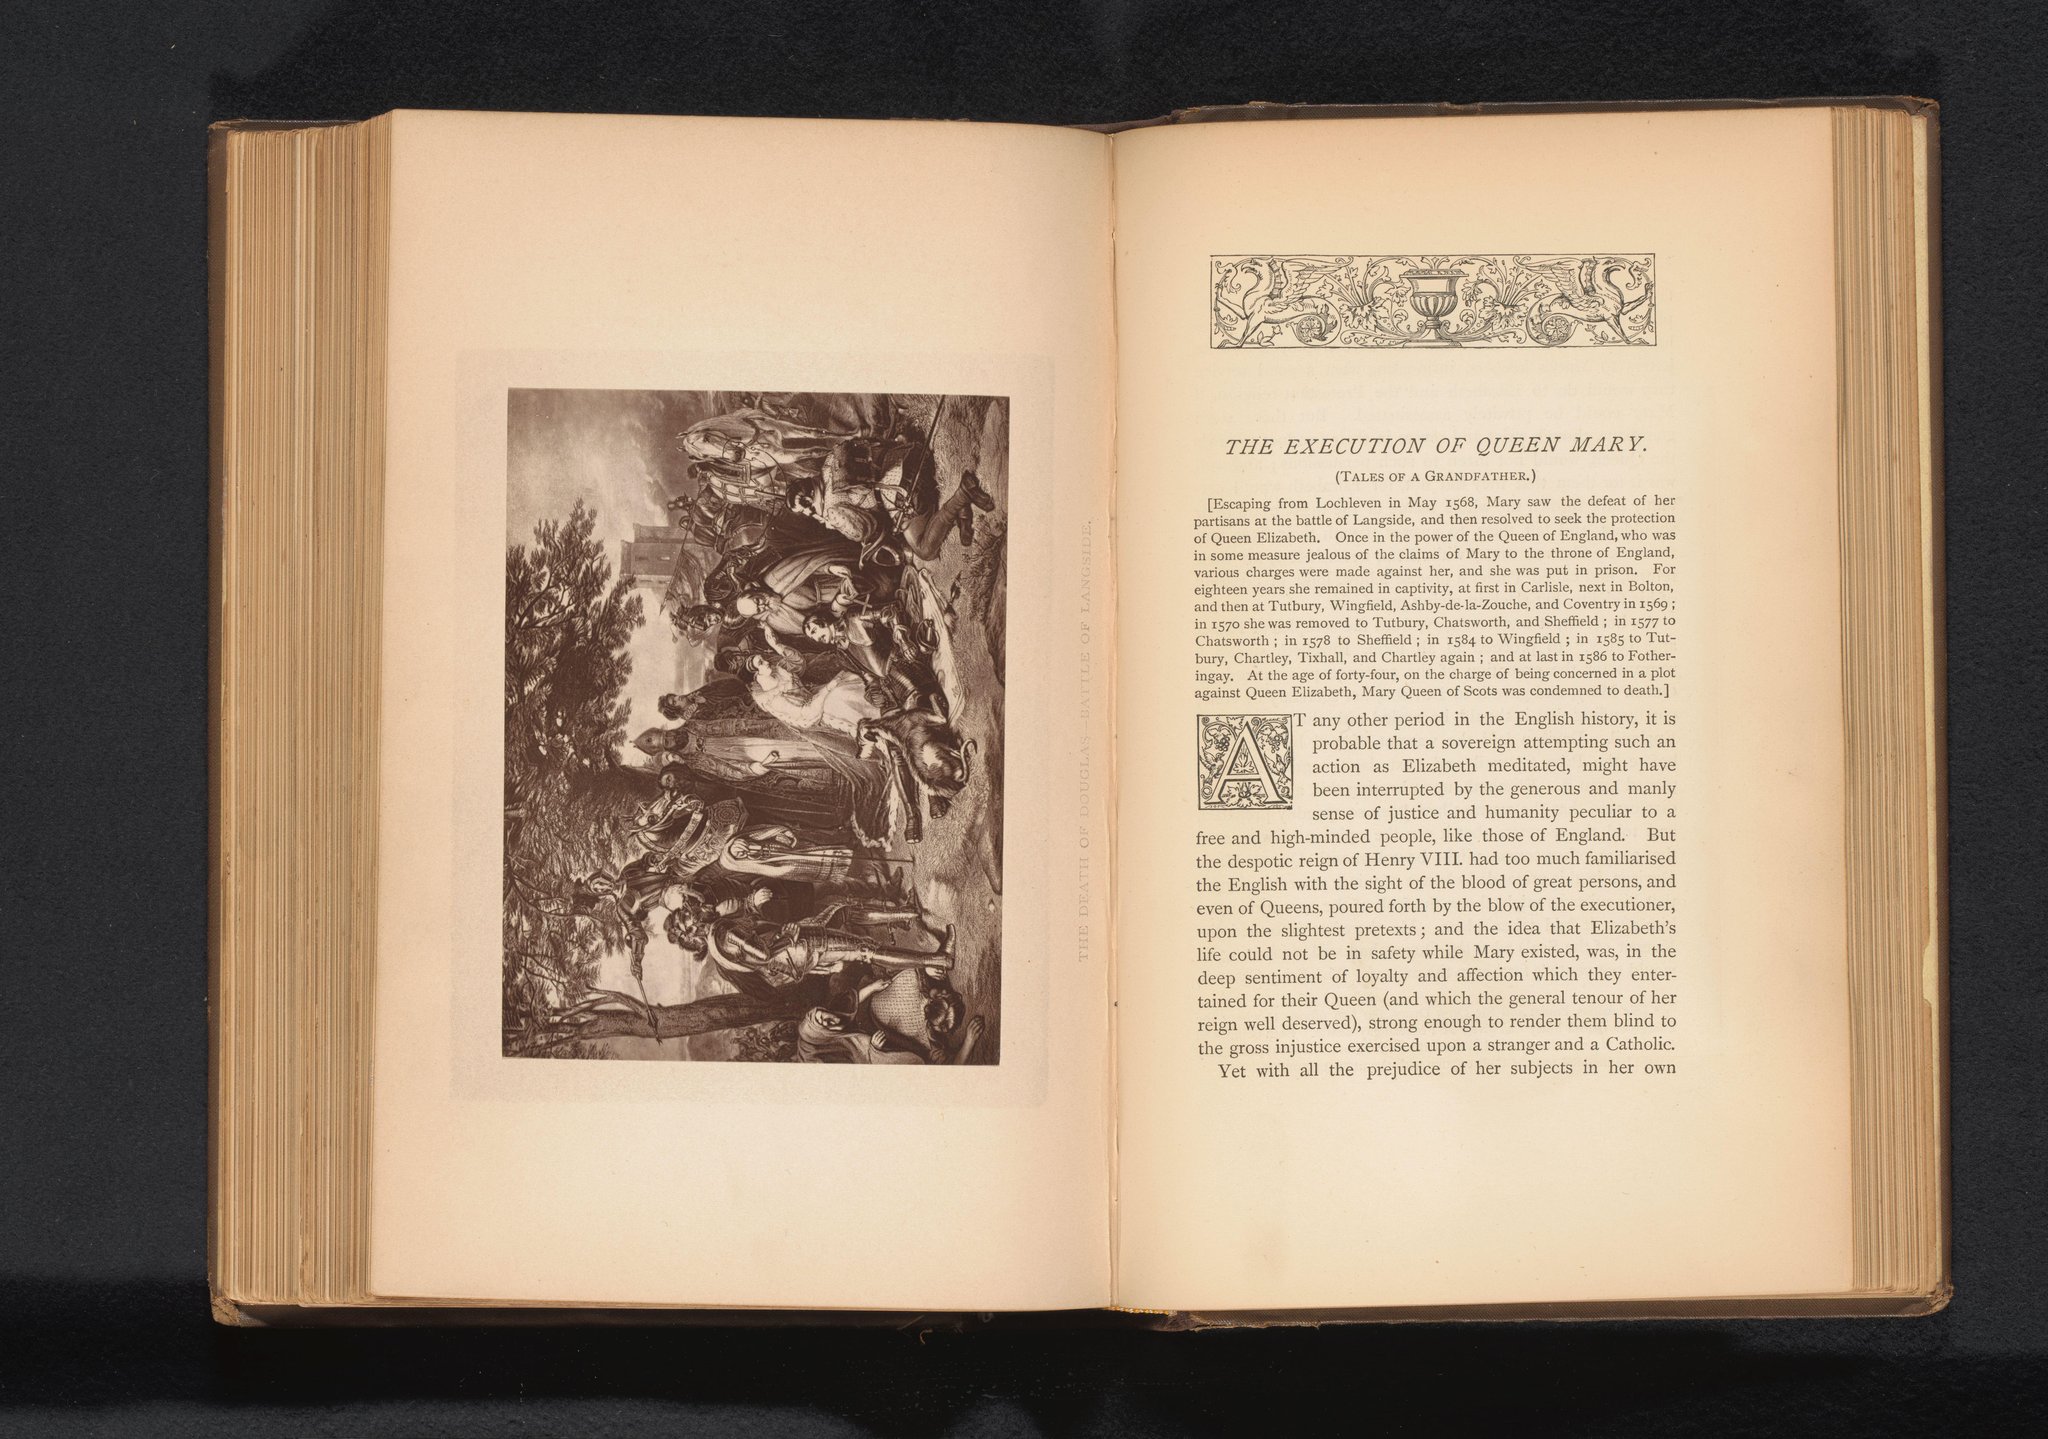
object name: reproduction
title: The death of Douglas-battle of Langside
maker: Anonymous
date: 1876-1881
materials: paper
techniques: woodburytype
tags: violent death by blows, kicks, pricks, etc. - ee - death not certain; wounded person, battle